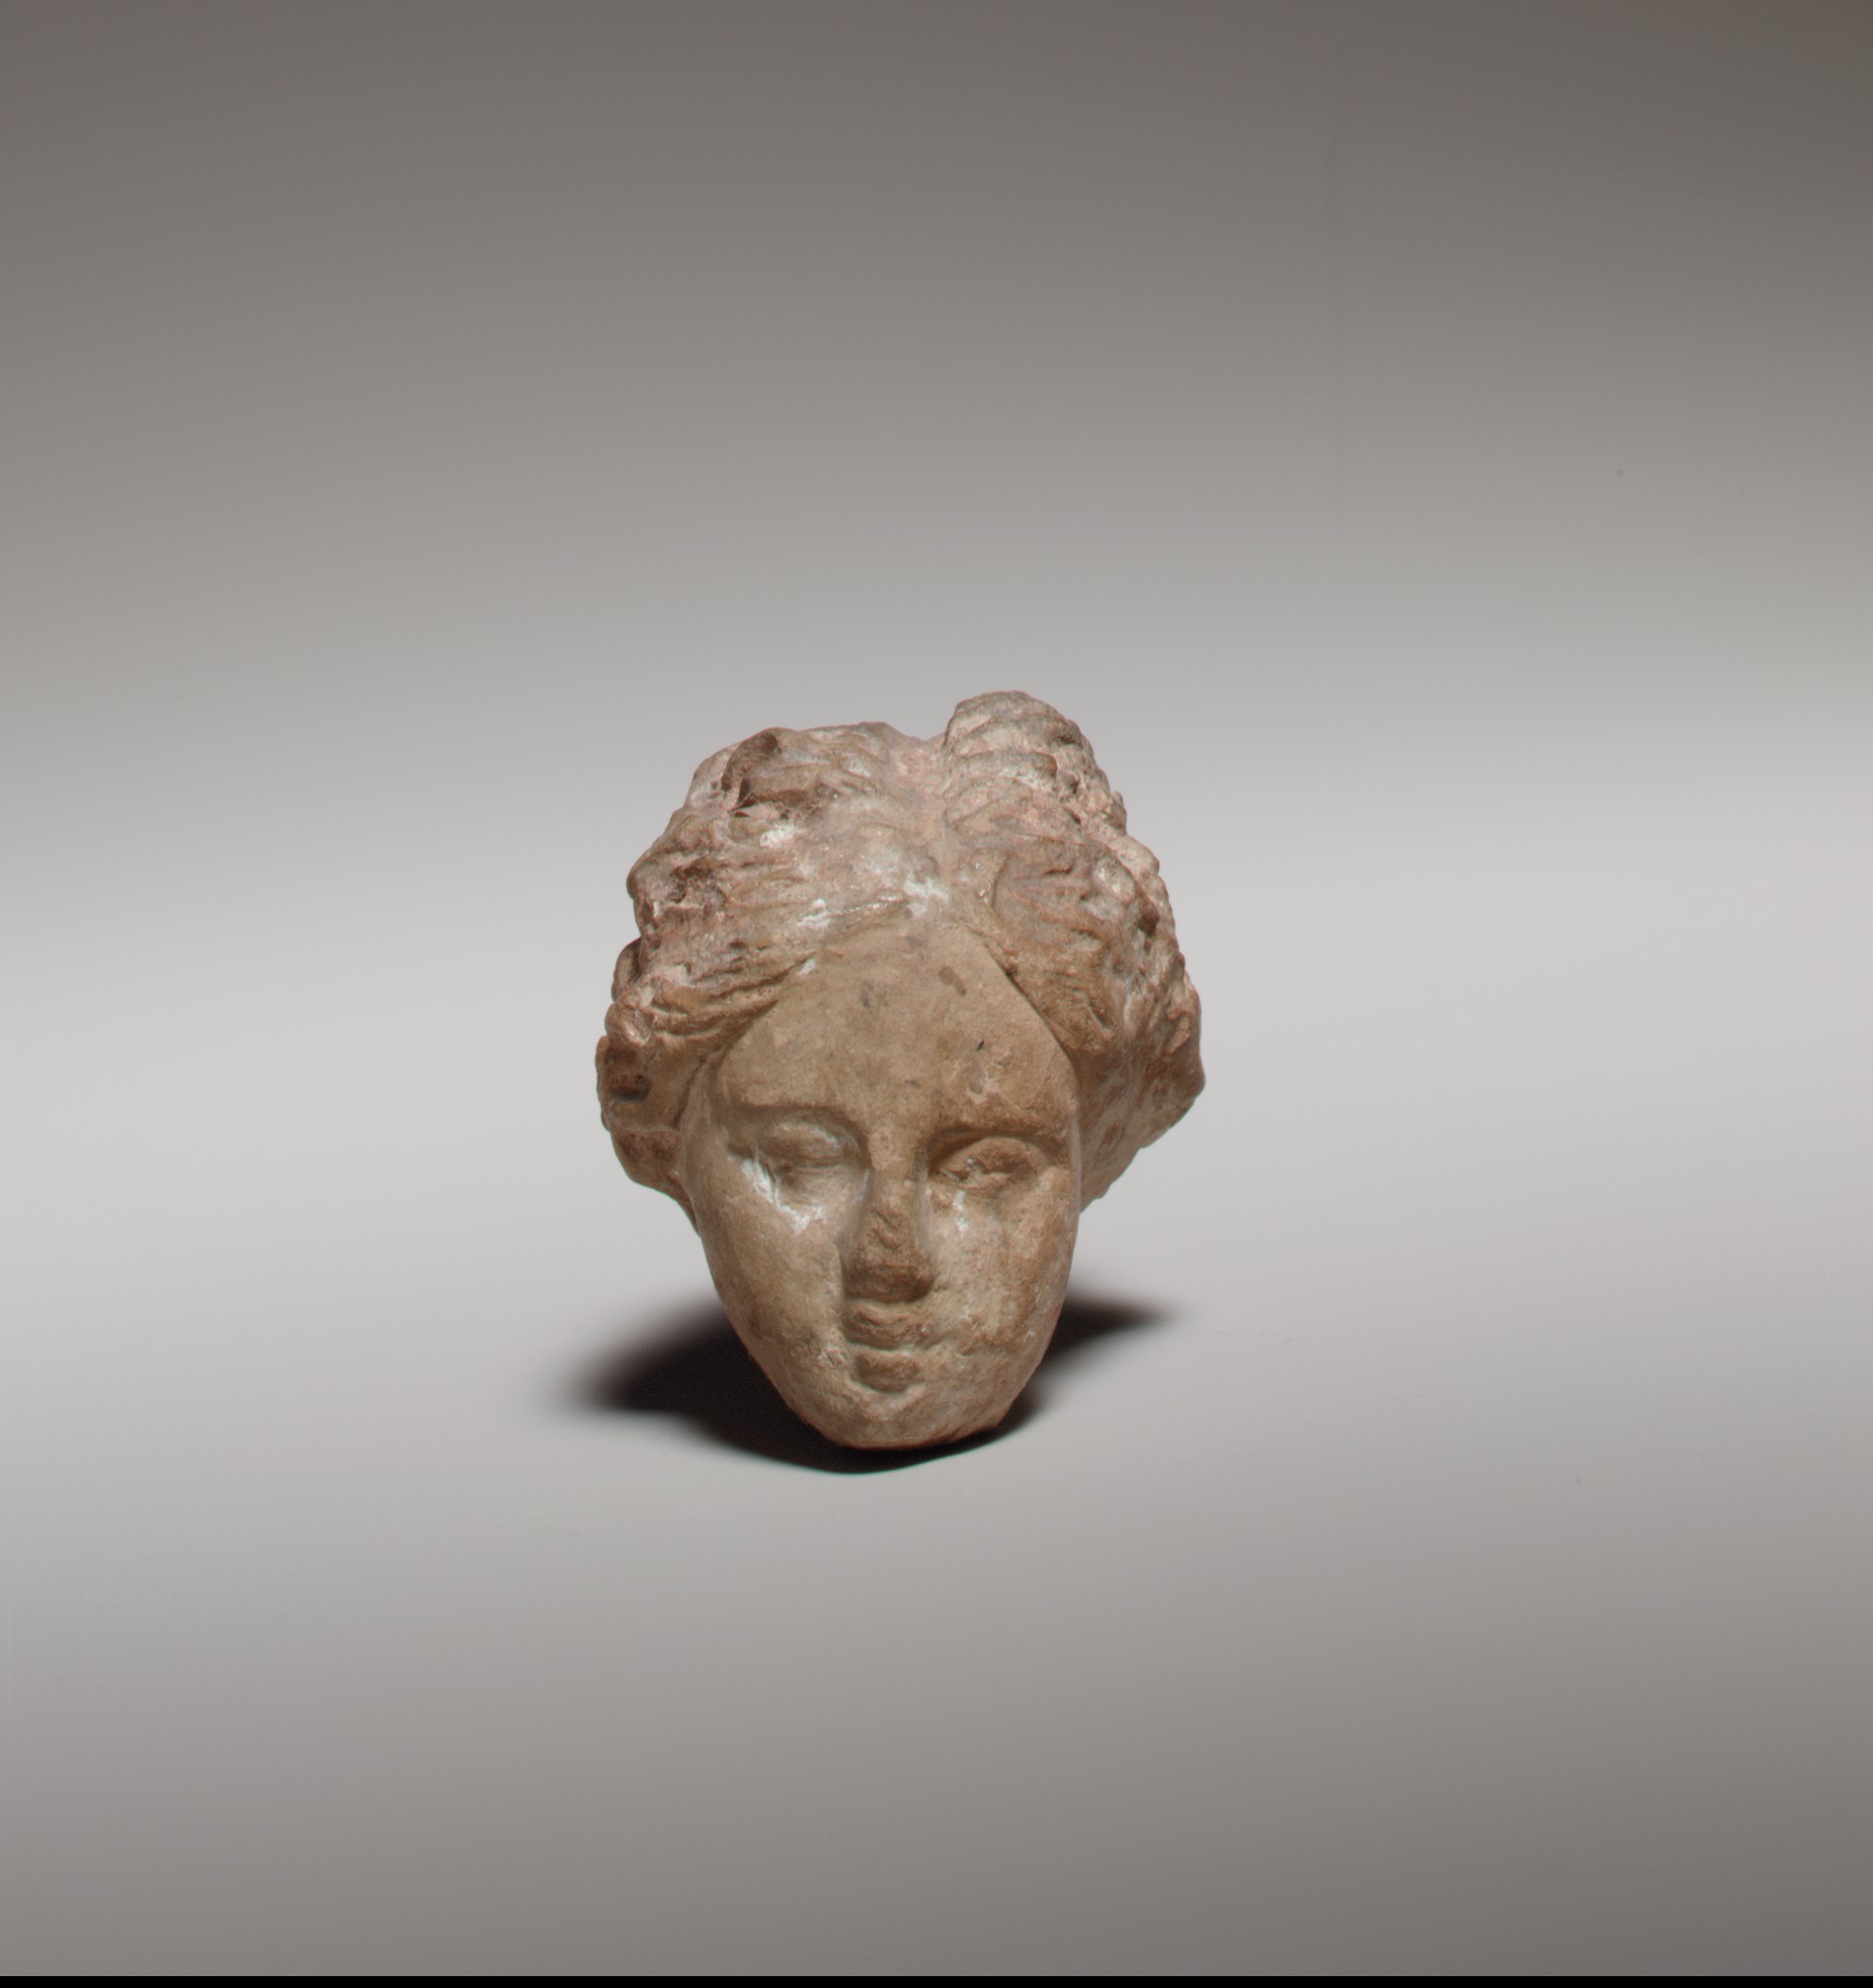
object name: head of a woman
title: Terracotta head of a woman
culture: greek, cypriot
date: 300-101 BCE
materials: terracotta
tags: heads,women